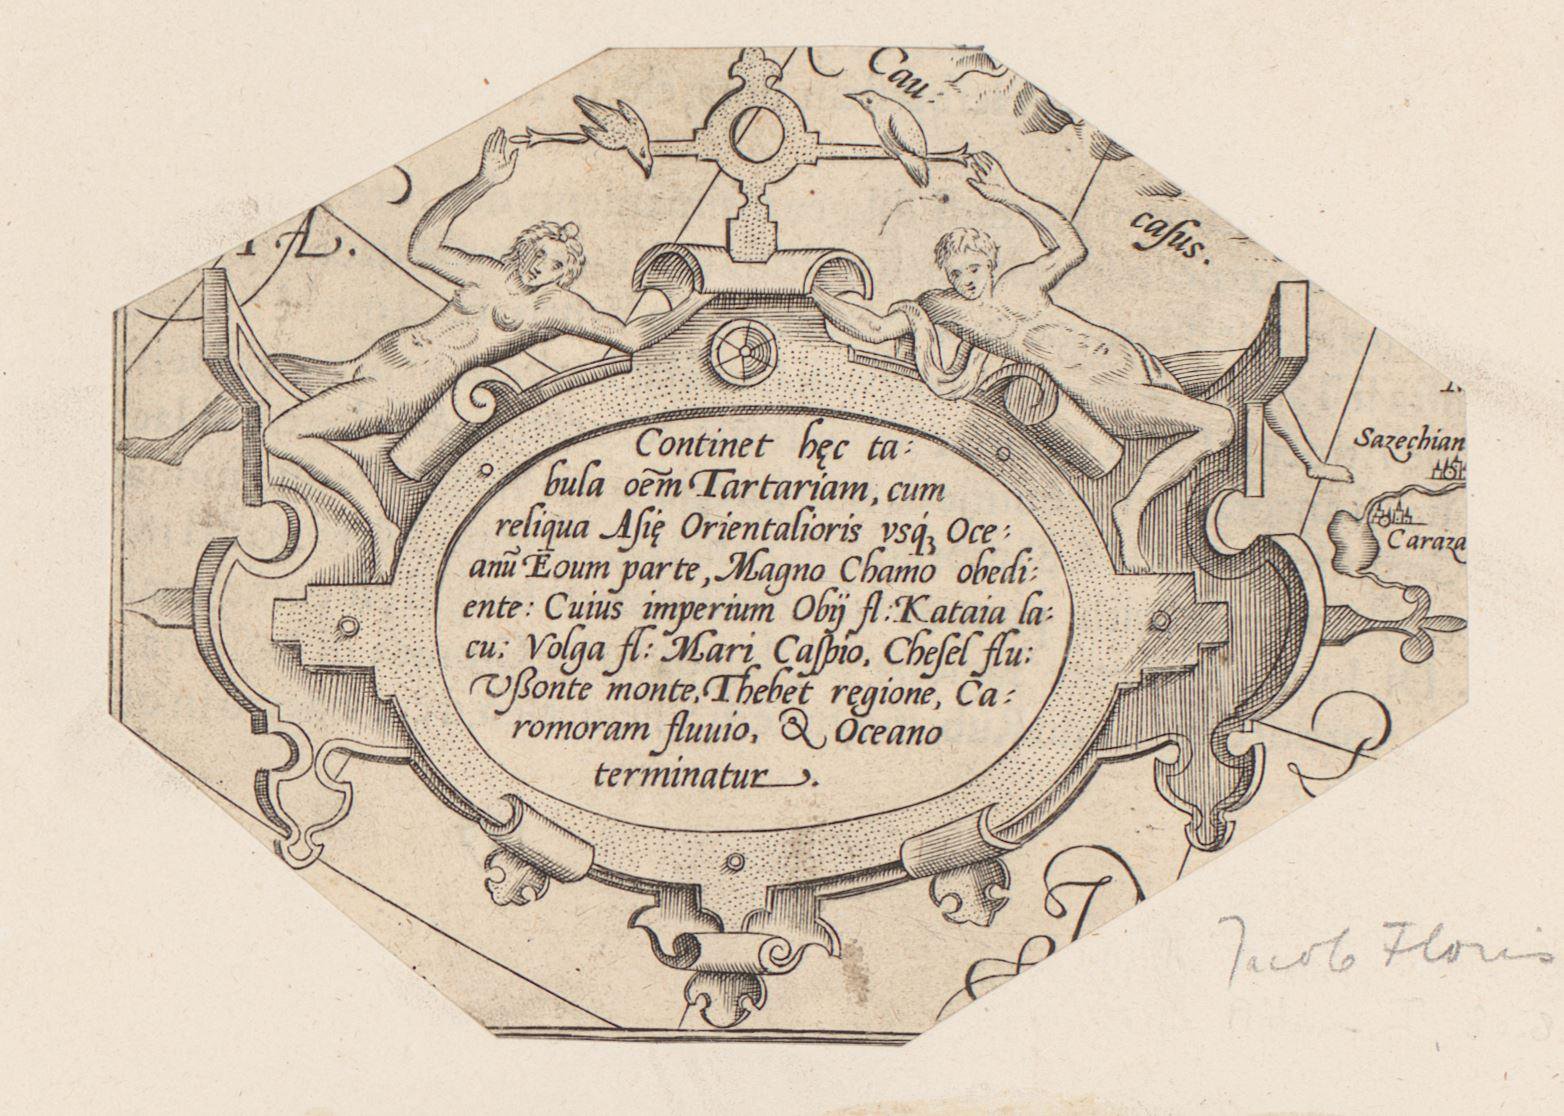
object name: print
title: Tartariae sive Magni Chami Regni typus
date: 1570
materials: paper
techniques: engraving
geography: antwerp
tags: scrollwork, strapwork ~ ornament, ornament ~ cartouche, leaning figure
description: Ovale cartouche met bovenaan een liggende naakte man en vrouw en twee vogels. De cartouche is een fragment van een kaart van Tartarije. De prent maakt deel uit van een album.